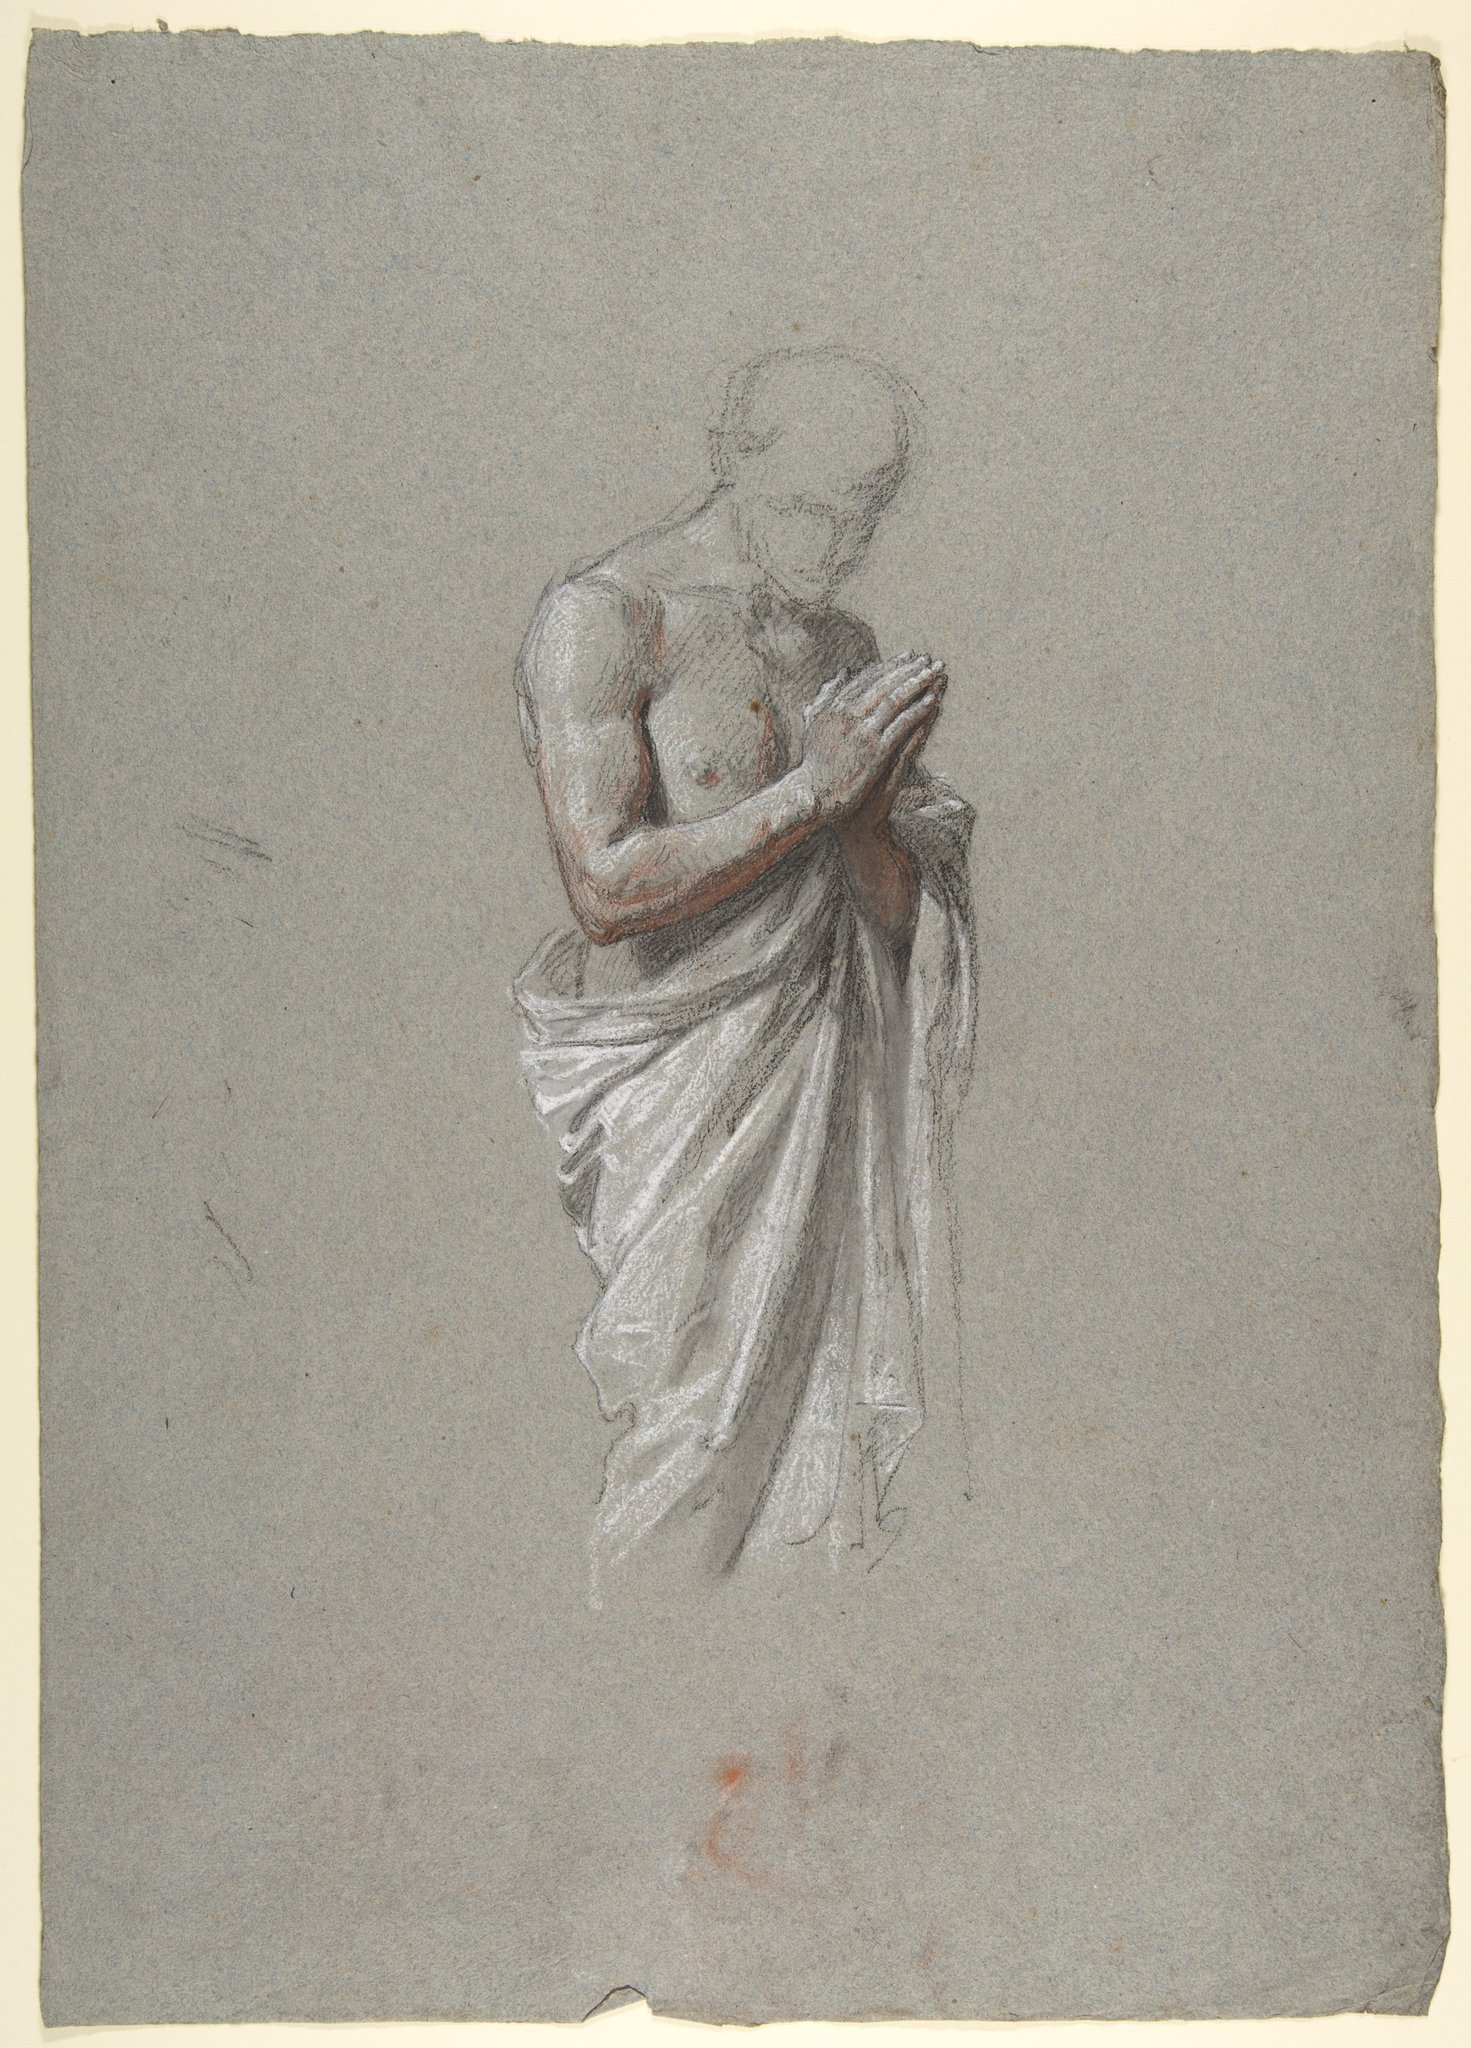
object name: drawing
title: Study for Clovis (middle register; study for wall paintings in the Chapel of Saint Remi, Sainte-Clotilde, Paris, 1858)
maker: isidore pils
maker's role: artist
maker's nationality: french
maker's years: 1813-1875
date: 1801-1900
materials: chalk, paper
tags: men,saints